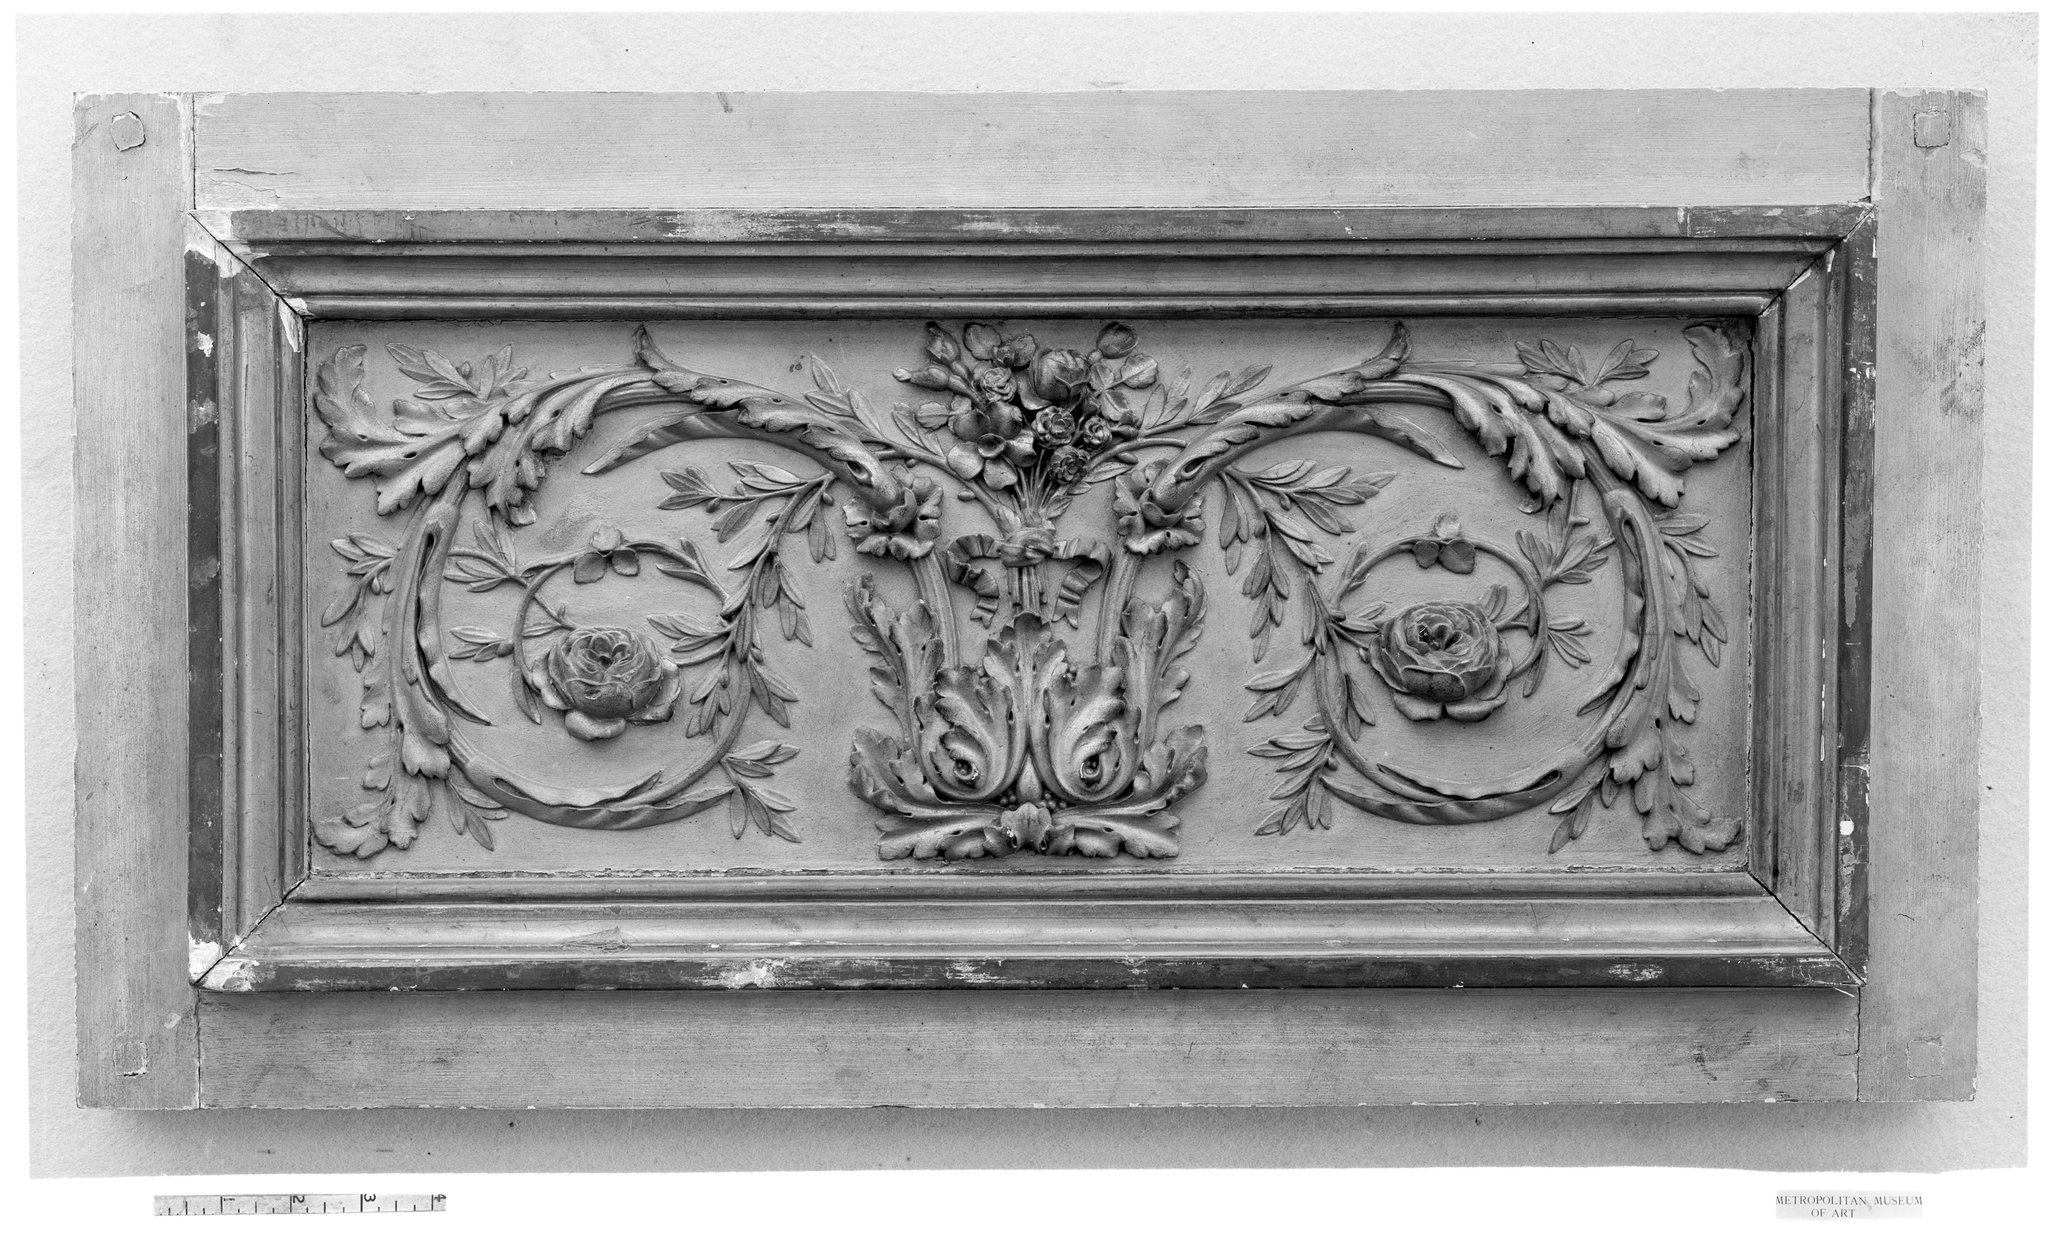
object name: panel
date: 1701-1800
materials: wood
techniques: carving, gilding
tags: roses